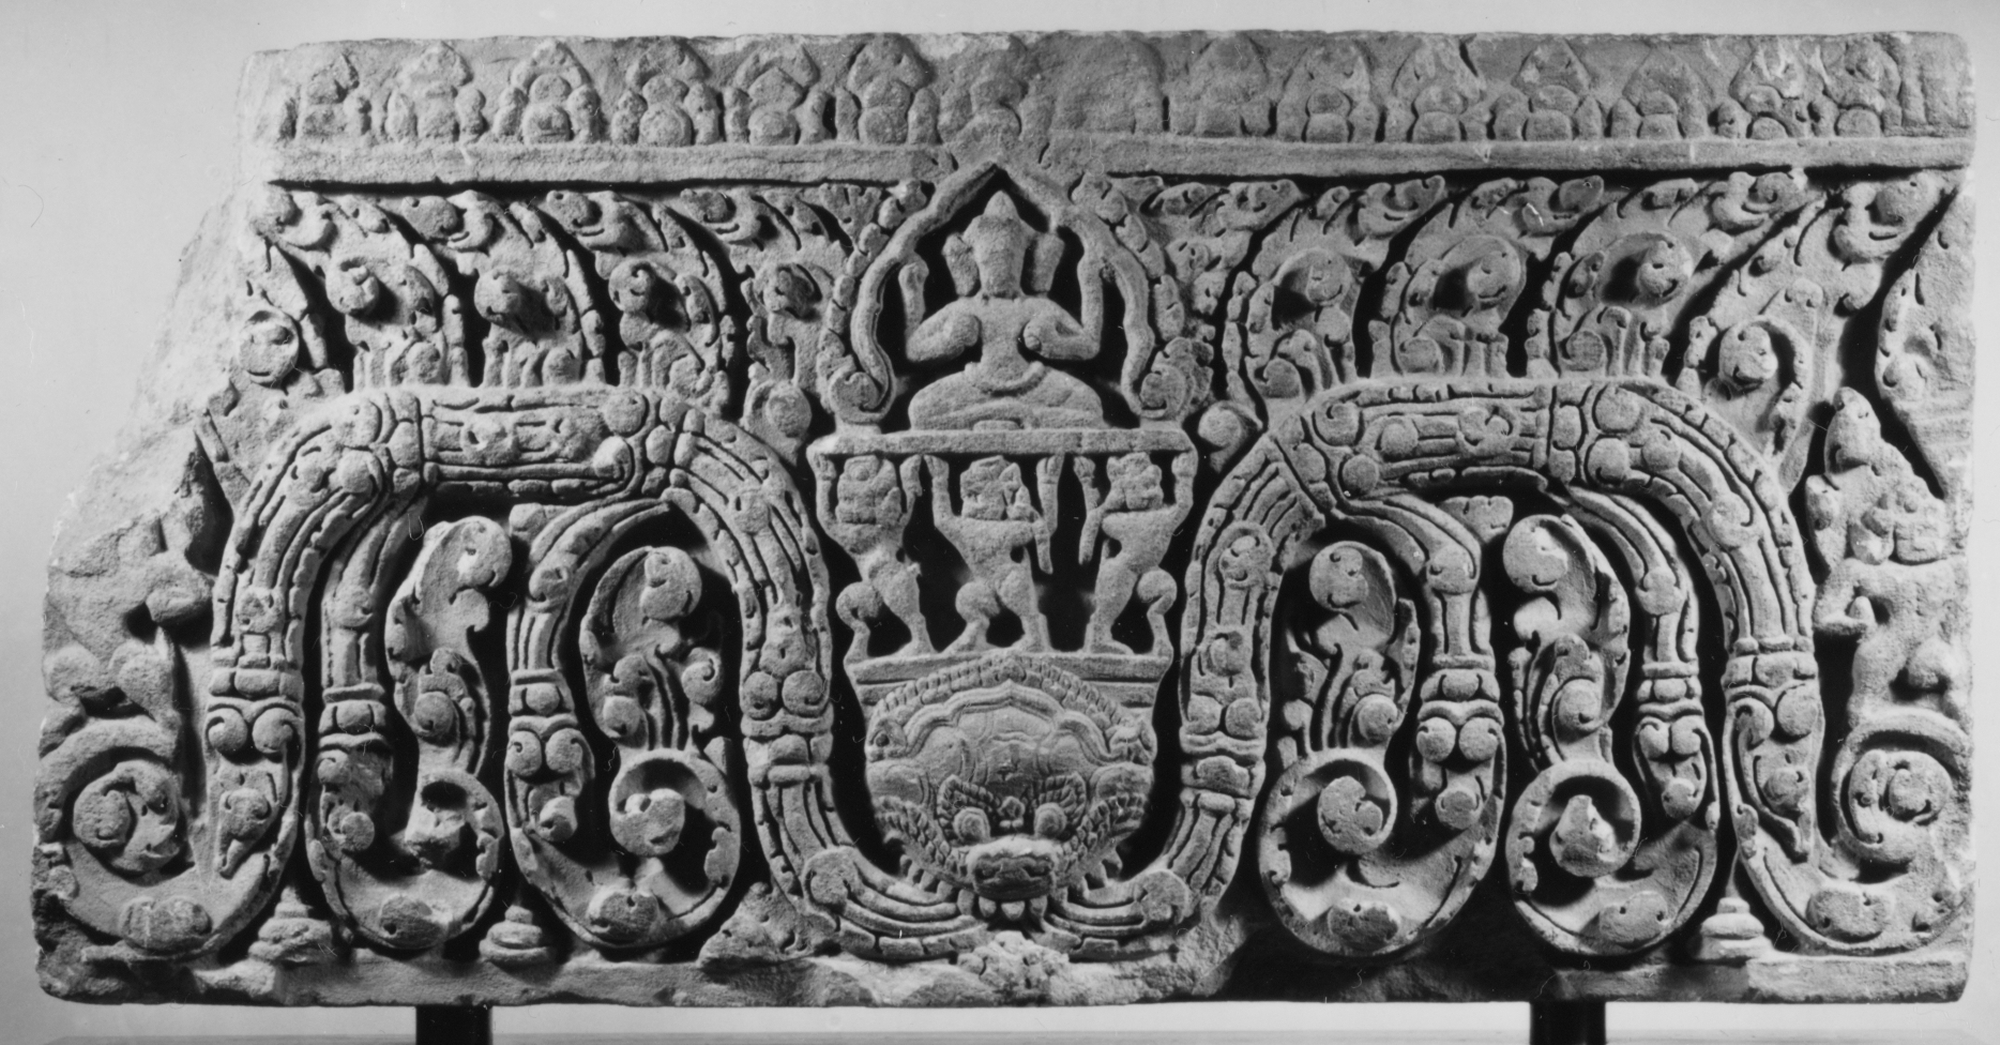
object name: lintel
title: Carved Lintel with Three-Headed Buddha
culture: cambodian or thai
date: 1101-1200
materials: stone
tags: buddhism,buddha